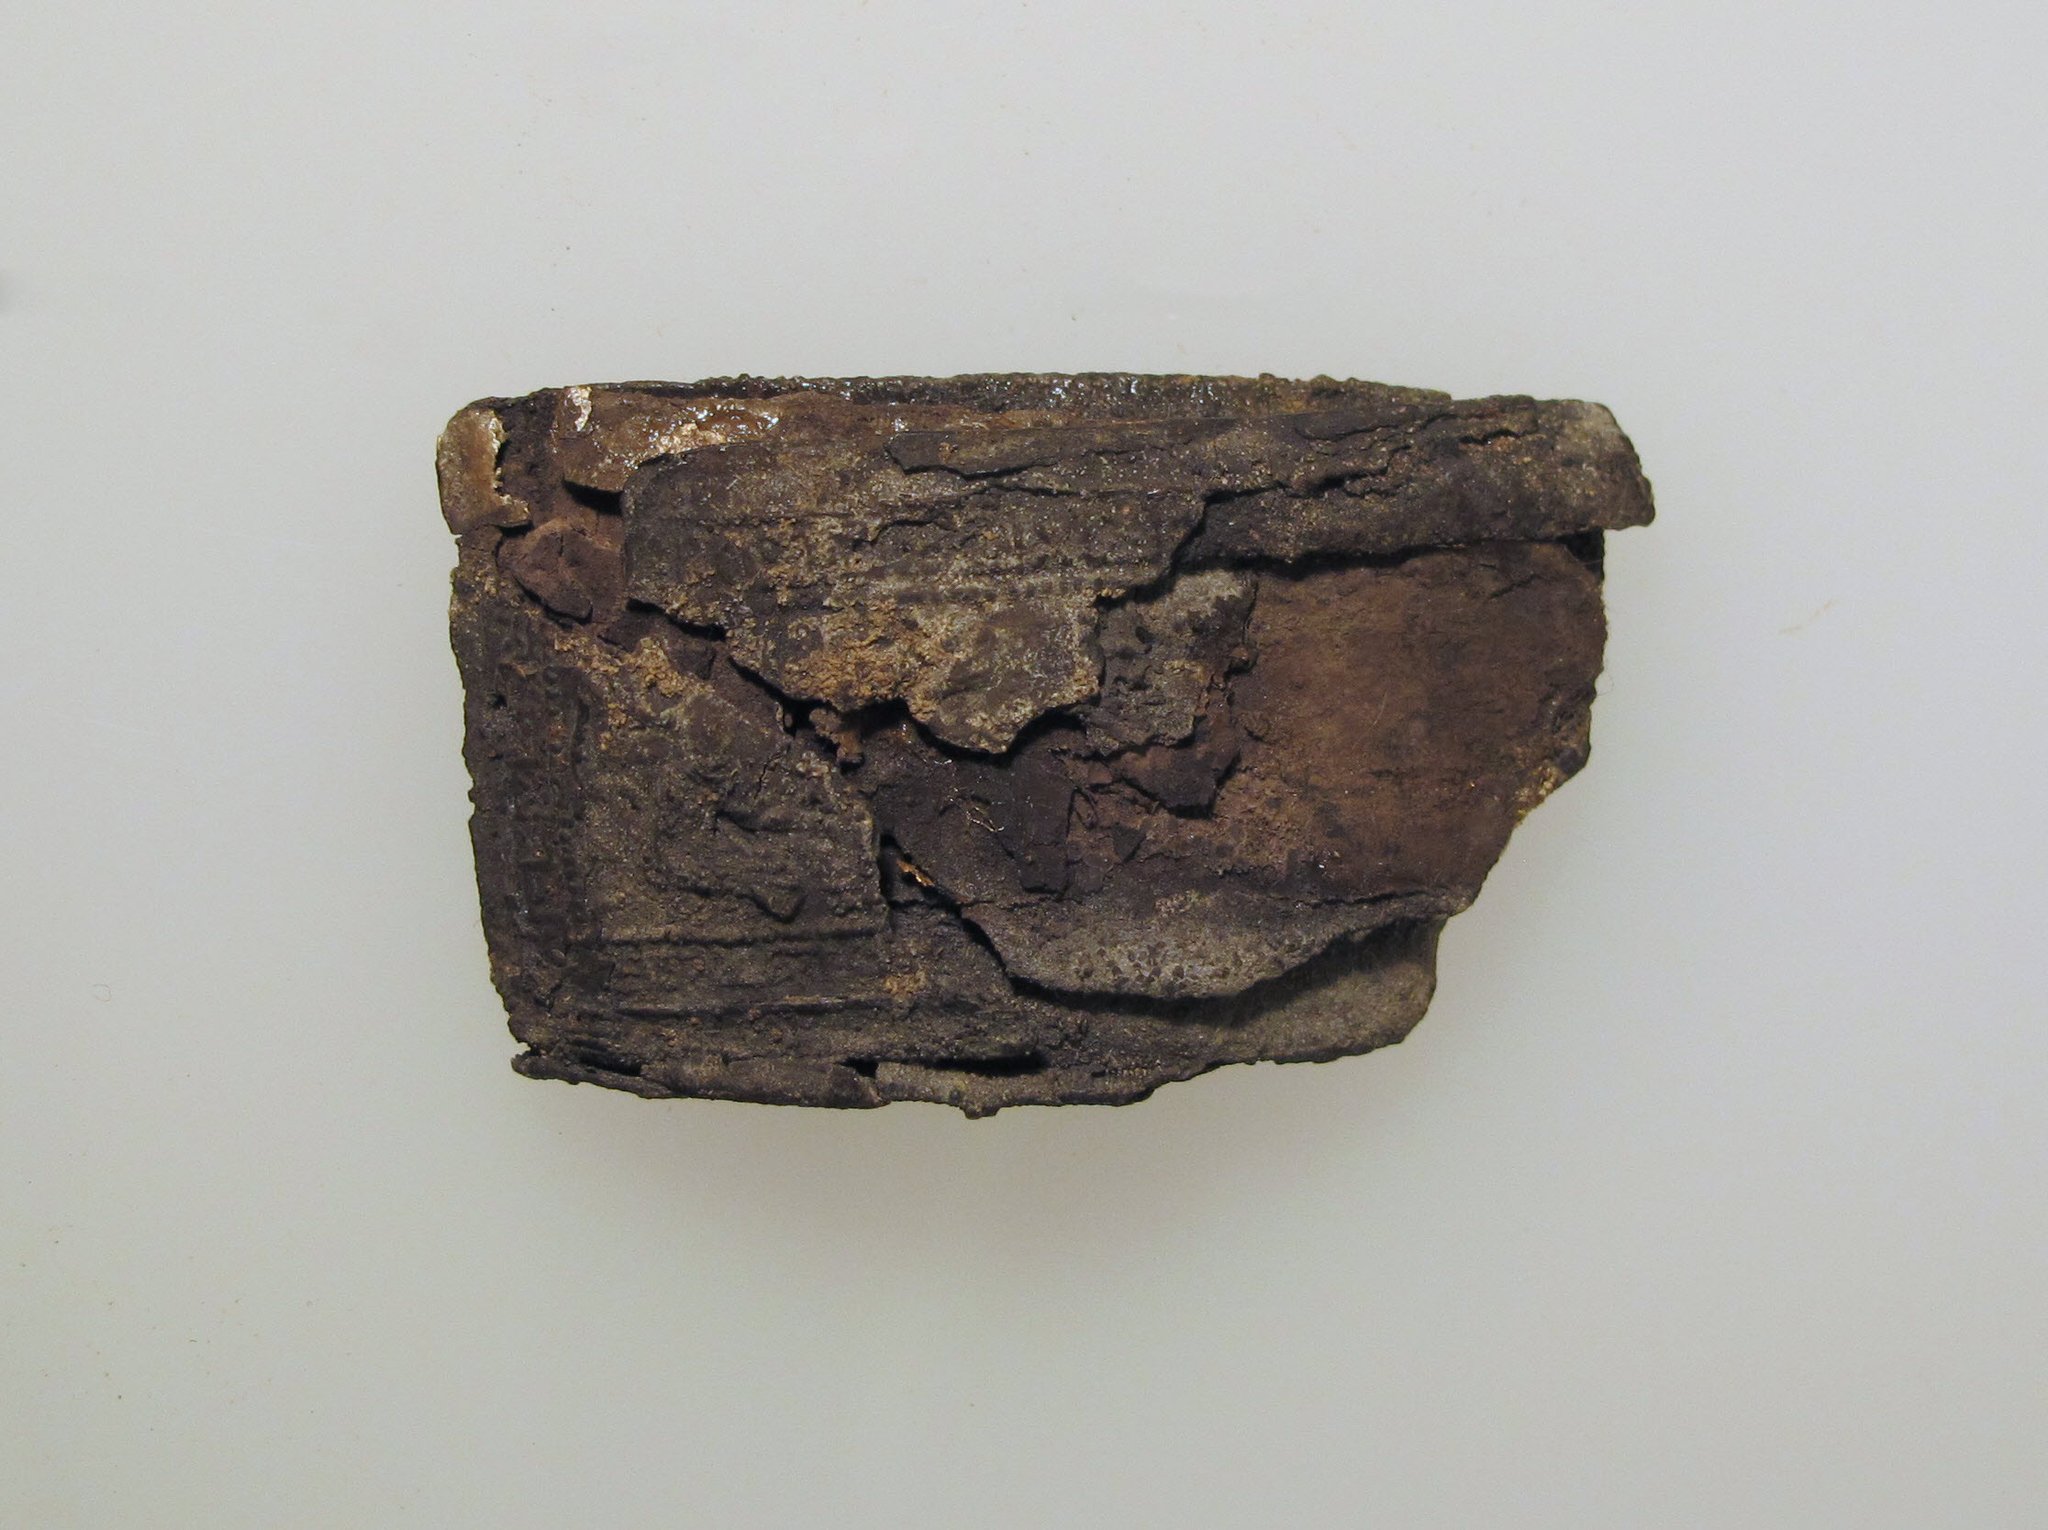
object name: bracelet fragment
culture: cypriot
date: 3900 BCE-100 CE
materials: silver